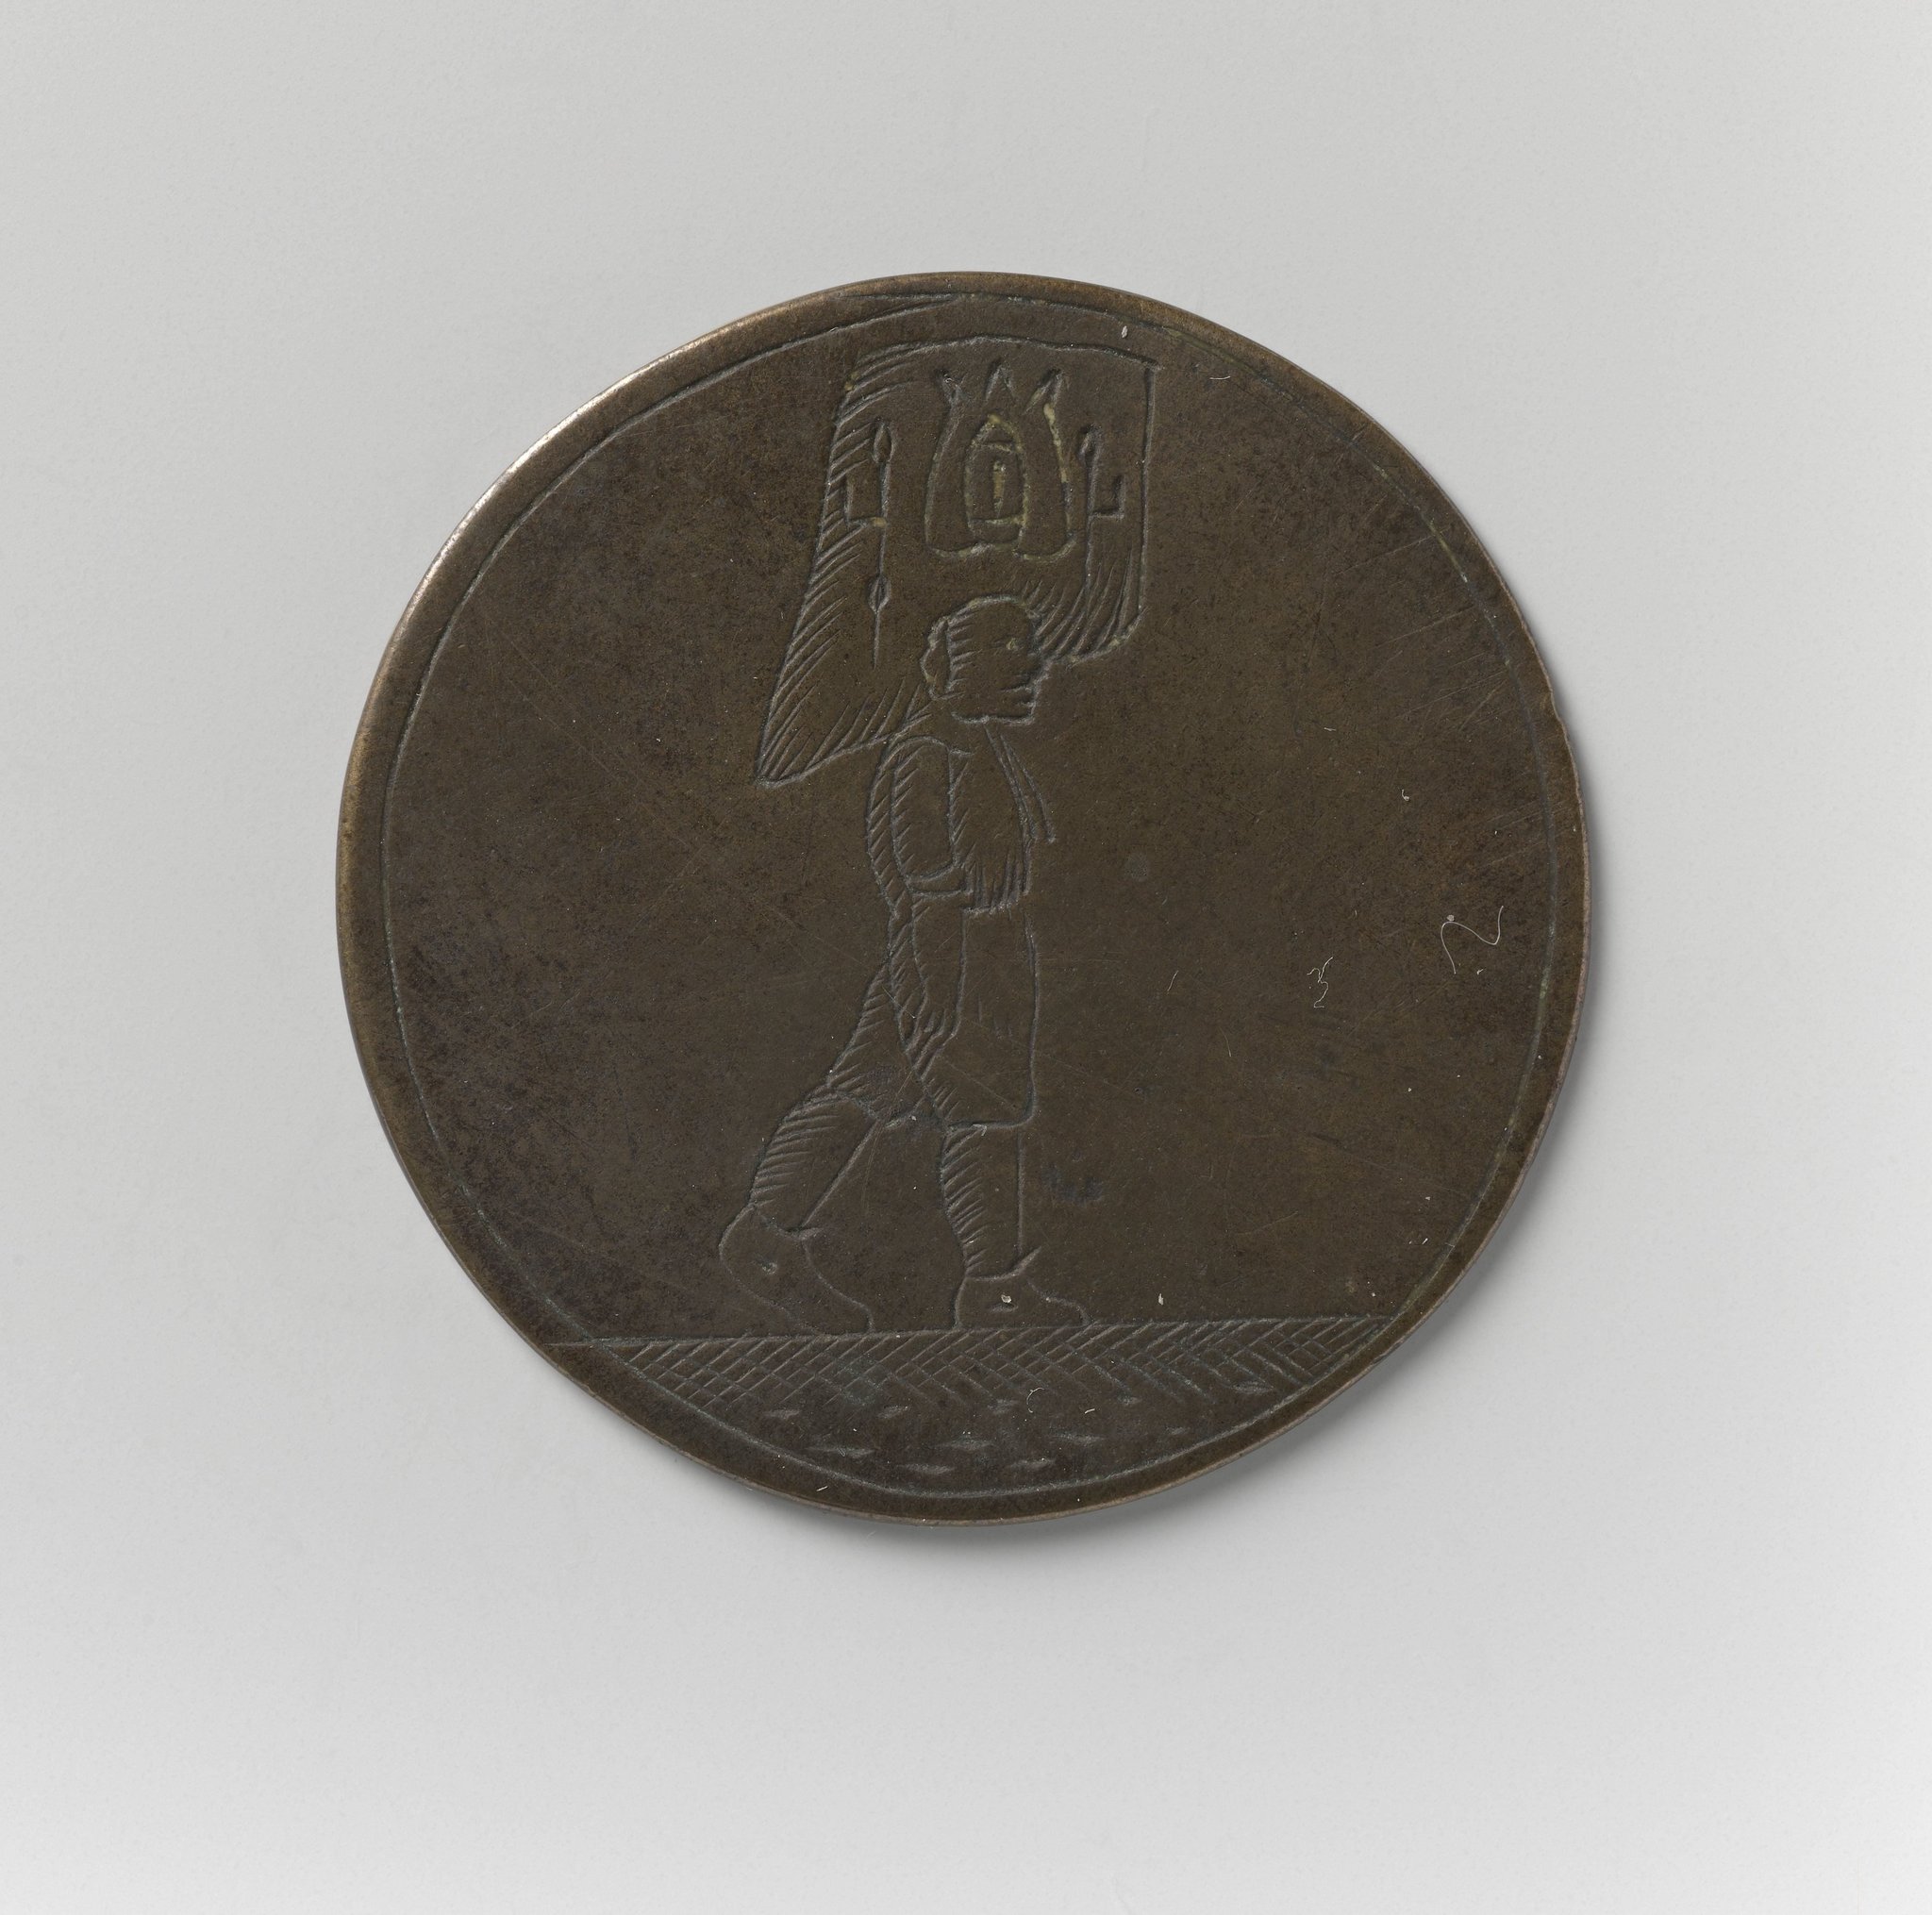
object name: medal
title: Korendragers- en -stortersgilde van Amsterdam, gildepenning van Barent Cortman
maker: Anonymous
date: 1730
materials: copper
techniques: engraving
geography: amsterdam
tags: amsterdam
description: Koperen penning. Voorzijde: naar rechts gewende man met last op hoofd. Keerzijde: opschrift